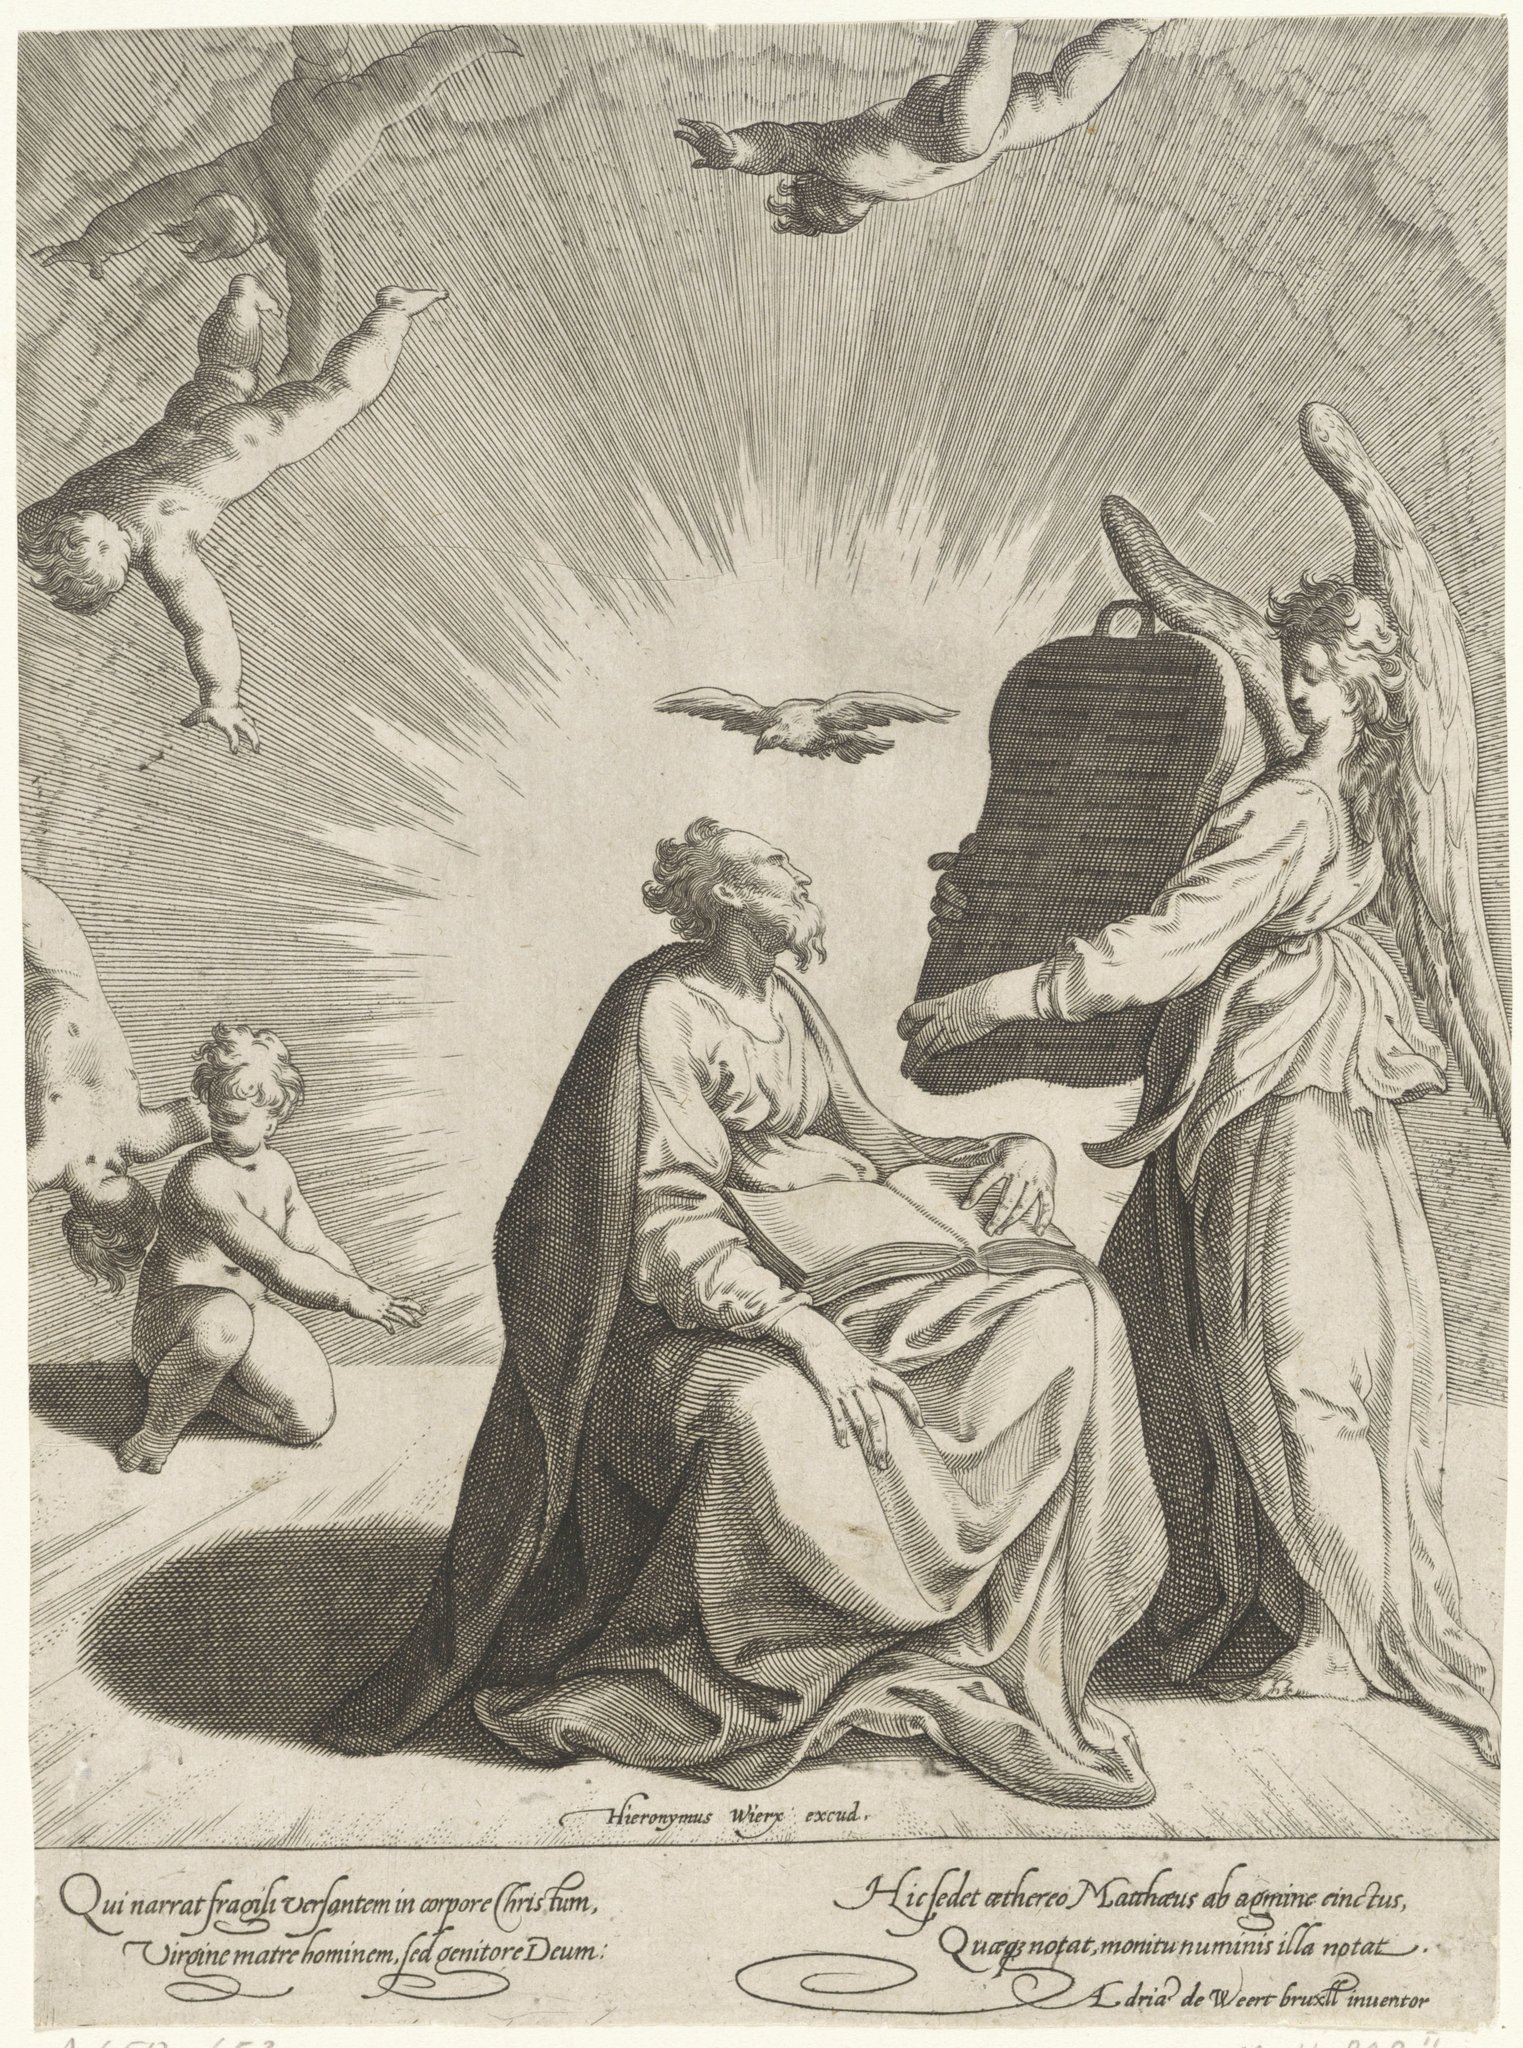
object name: print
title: Vier evangelisten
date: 1563-1590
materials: paper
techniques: engraving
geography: antwerp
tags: the apostle and evangelist matthew (mattheus); possible attributes: angel, axe, book, halberd, pen and inkhorn, purse, scroll, square, sword, holy ghost represented as a dove (in flames)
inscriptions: collector's mark: Lugt 2228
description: De evangelist Matteüs zit met opengeslagen boek op schoot. De engel toont hem de tafelen der wet. Boven het hoofd van Matteüs de duif van de Heilige Geest. Engeltjes vliegen door de lucht. In de marge een vierregelig onderschrift, in twee kolommen, in het Latijn.